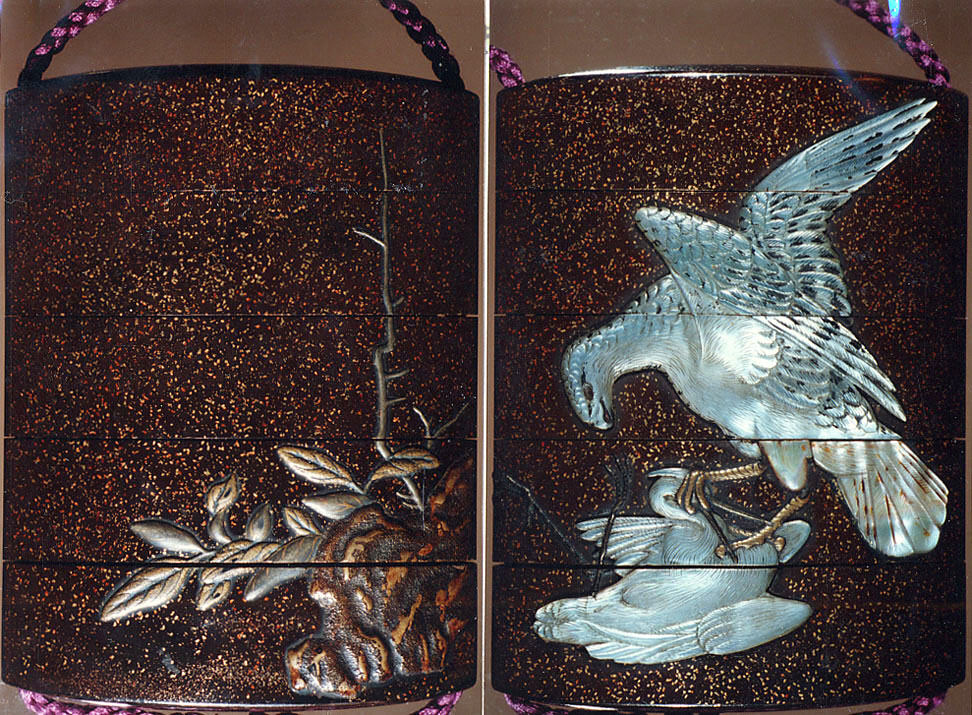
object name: inrō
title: Case (Inrō) with Design of Hawk Attacking Crane beside Rocks and Plants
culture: japanese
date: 1801-1900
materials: gold, lacquer, silver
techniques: fundame, hiramakie, inlay, roiro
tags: cranes,hawks,plants